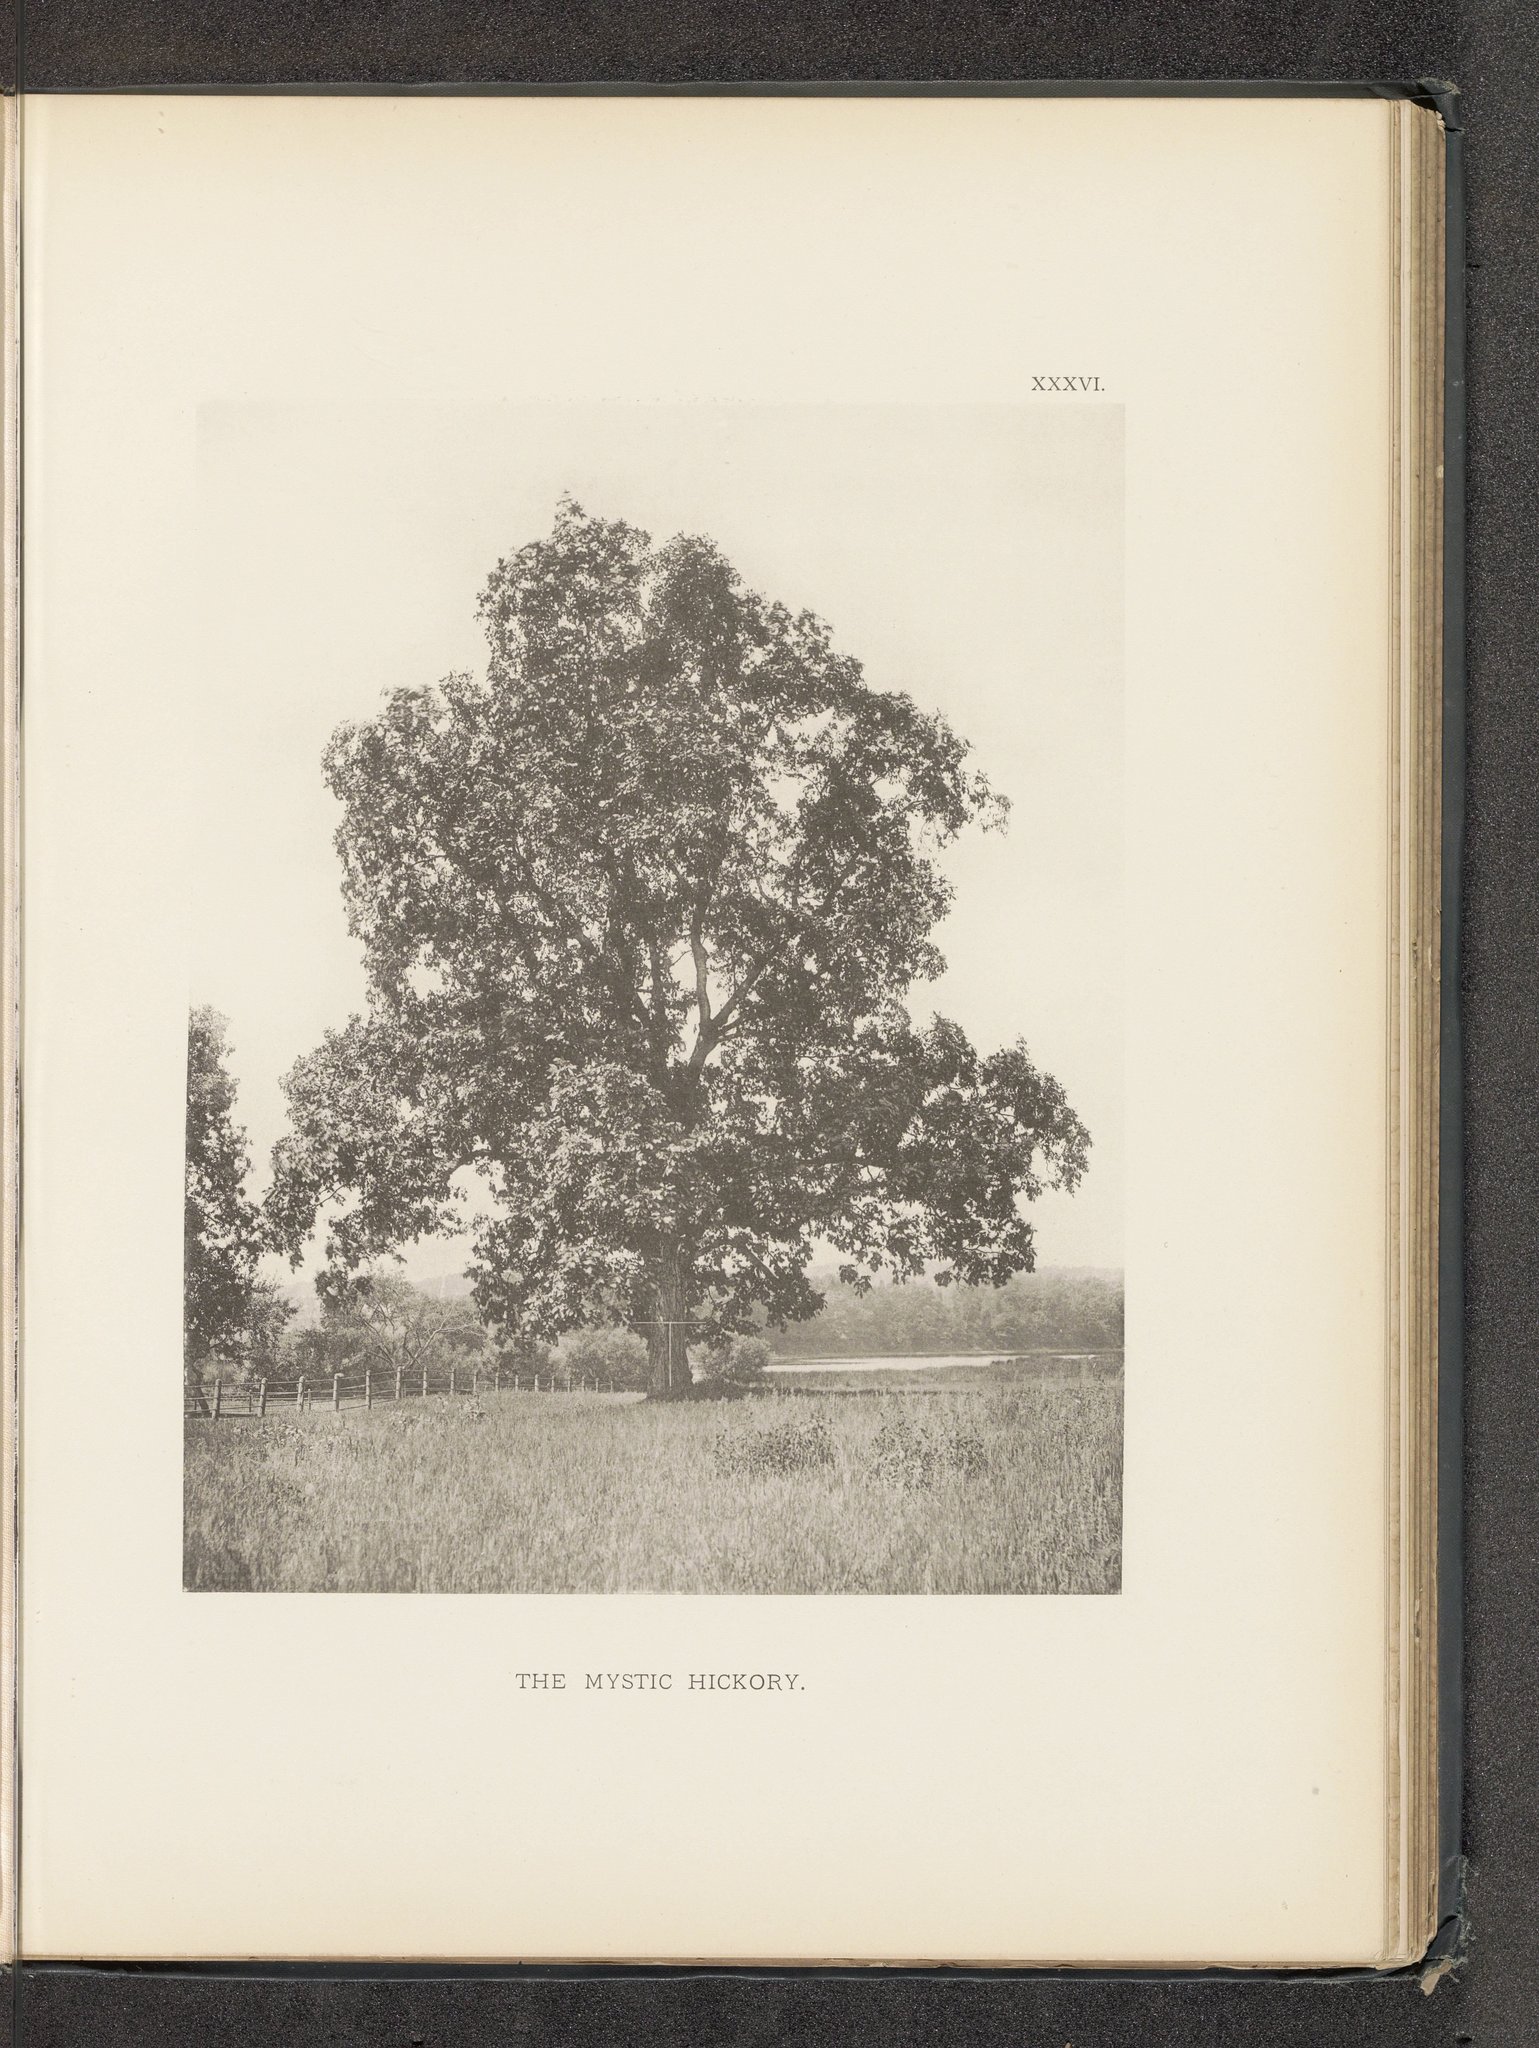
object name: photomechanical print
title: The mystic hickory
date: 1880-1890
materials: paper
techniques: photograph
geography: massachusetts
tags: plants; vegetation, meadow, pasture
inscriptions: number: ‘XXXVI.’